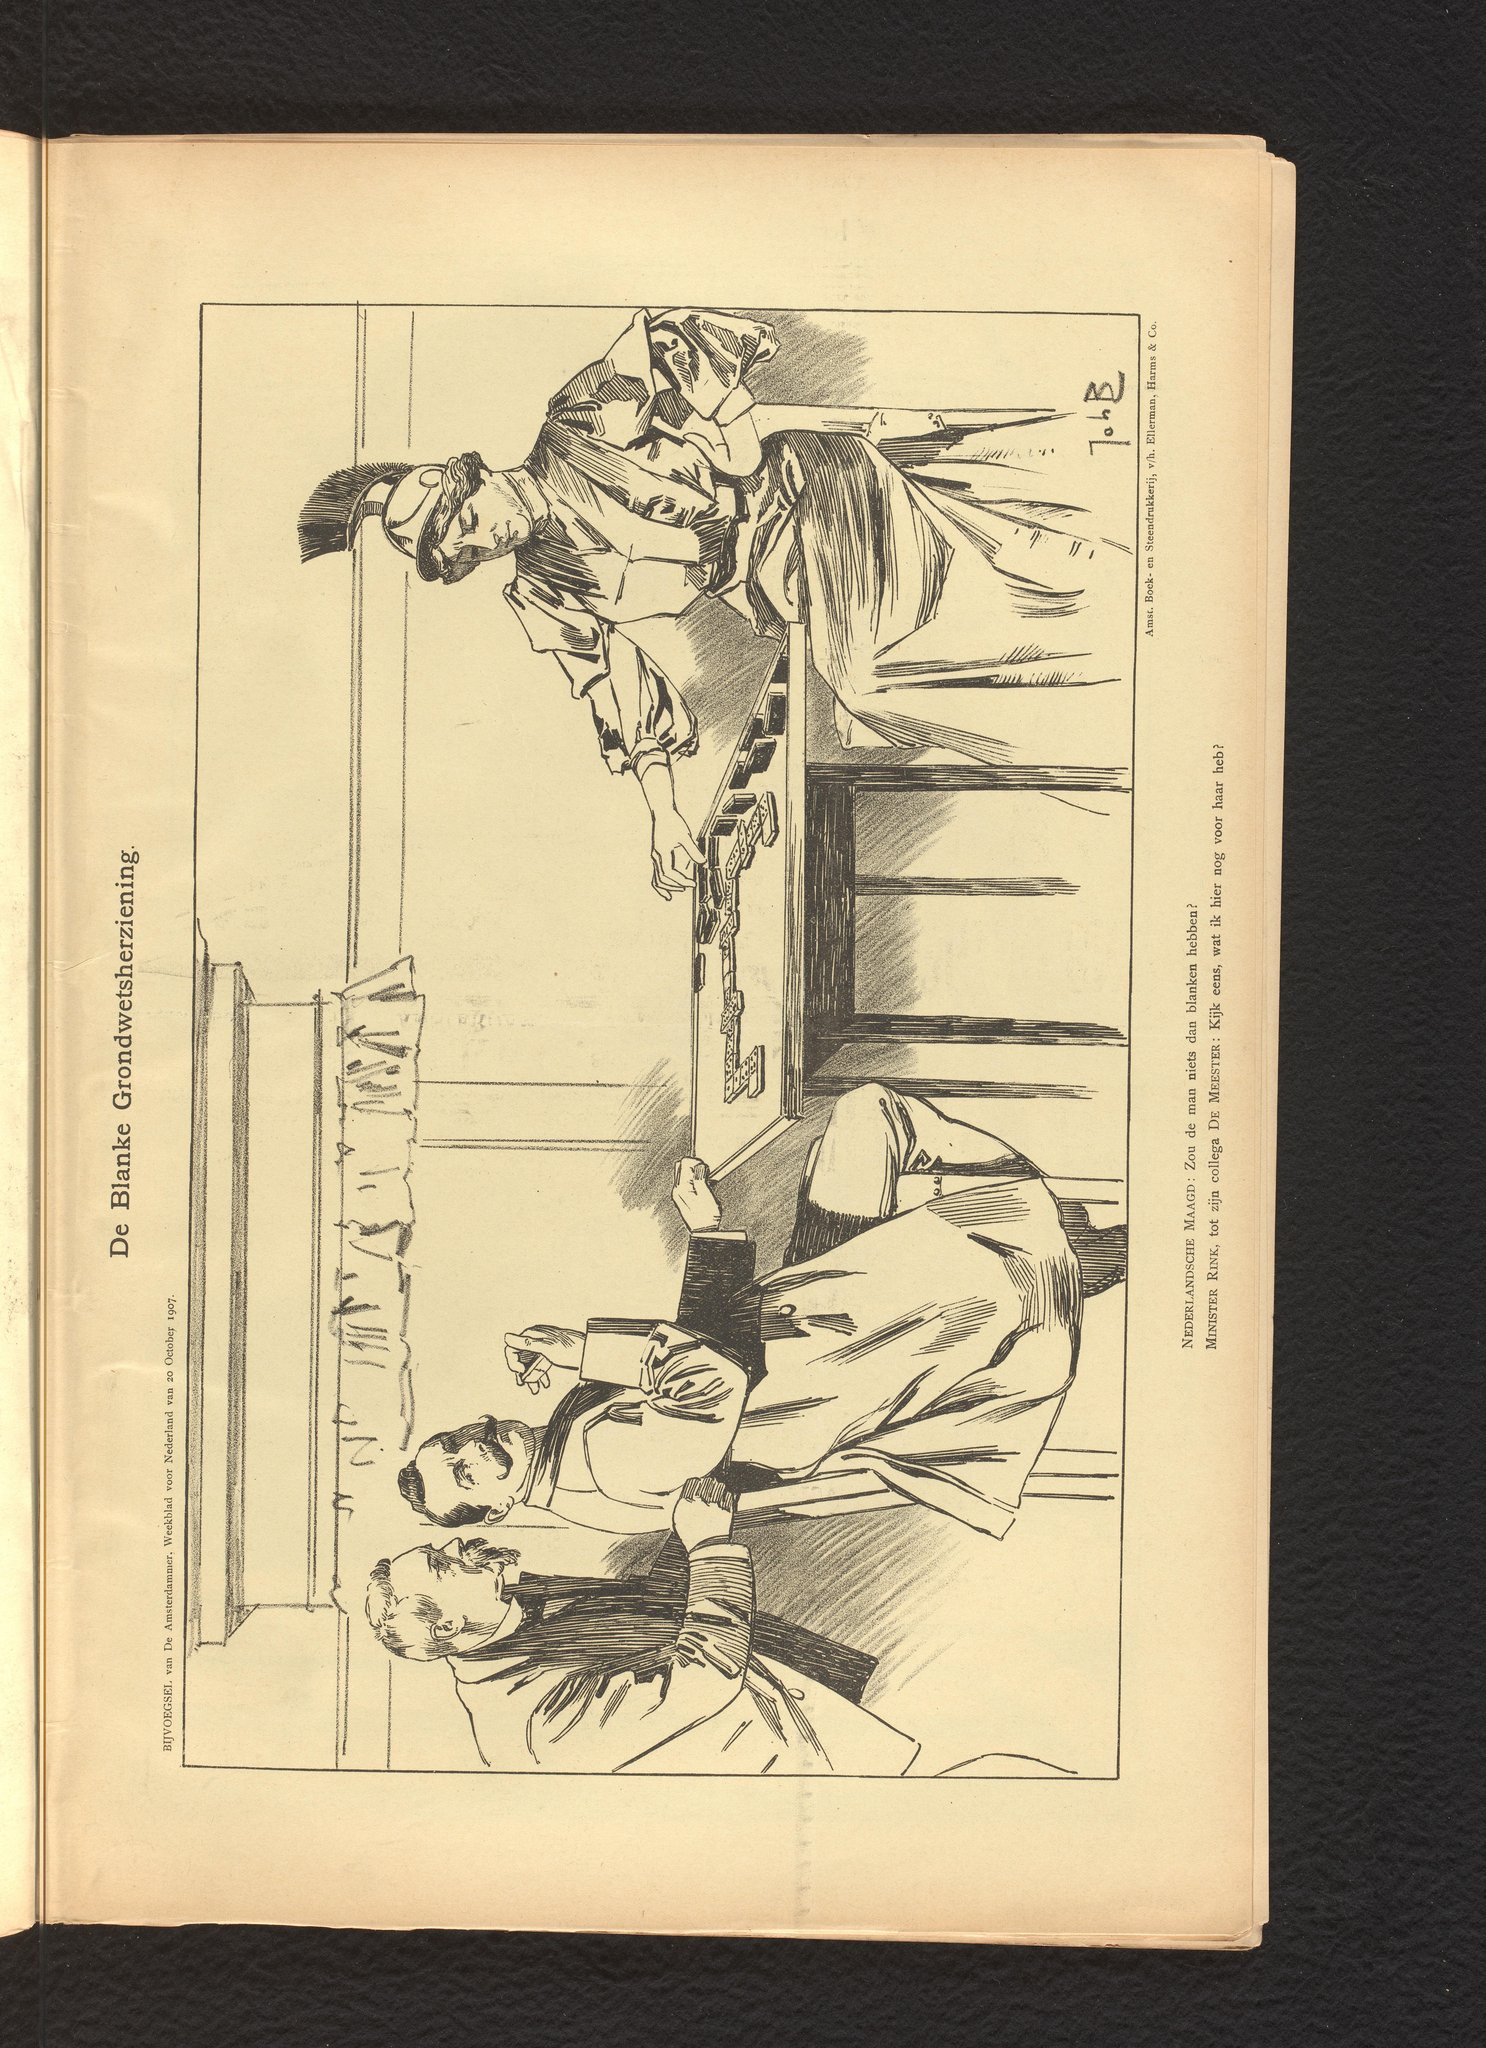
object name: cartoon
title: De Blanke Grondwetsherziening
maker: johan braakensiek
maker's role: draughtsman, print maker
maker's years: 1858-1940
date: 1907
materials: paper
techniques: lithograph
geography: amsterdam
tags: personifications of countries, nations, states, districts, etc., dominoes, political caricatures and satires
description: Minister van Binnenlandse Zaken Pieter Rink laat premier Theo de Meester zien dat hij het spelletje domino met de Nederlandse Maagd gaat winnen.